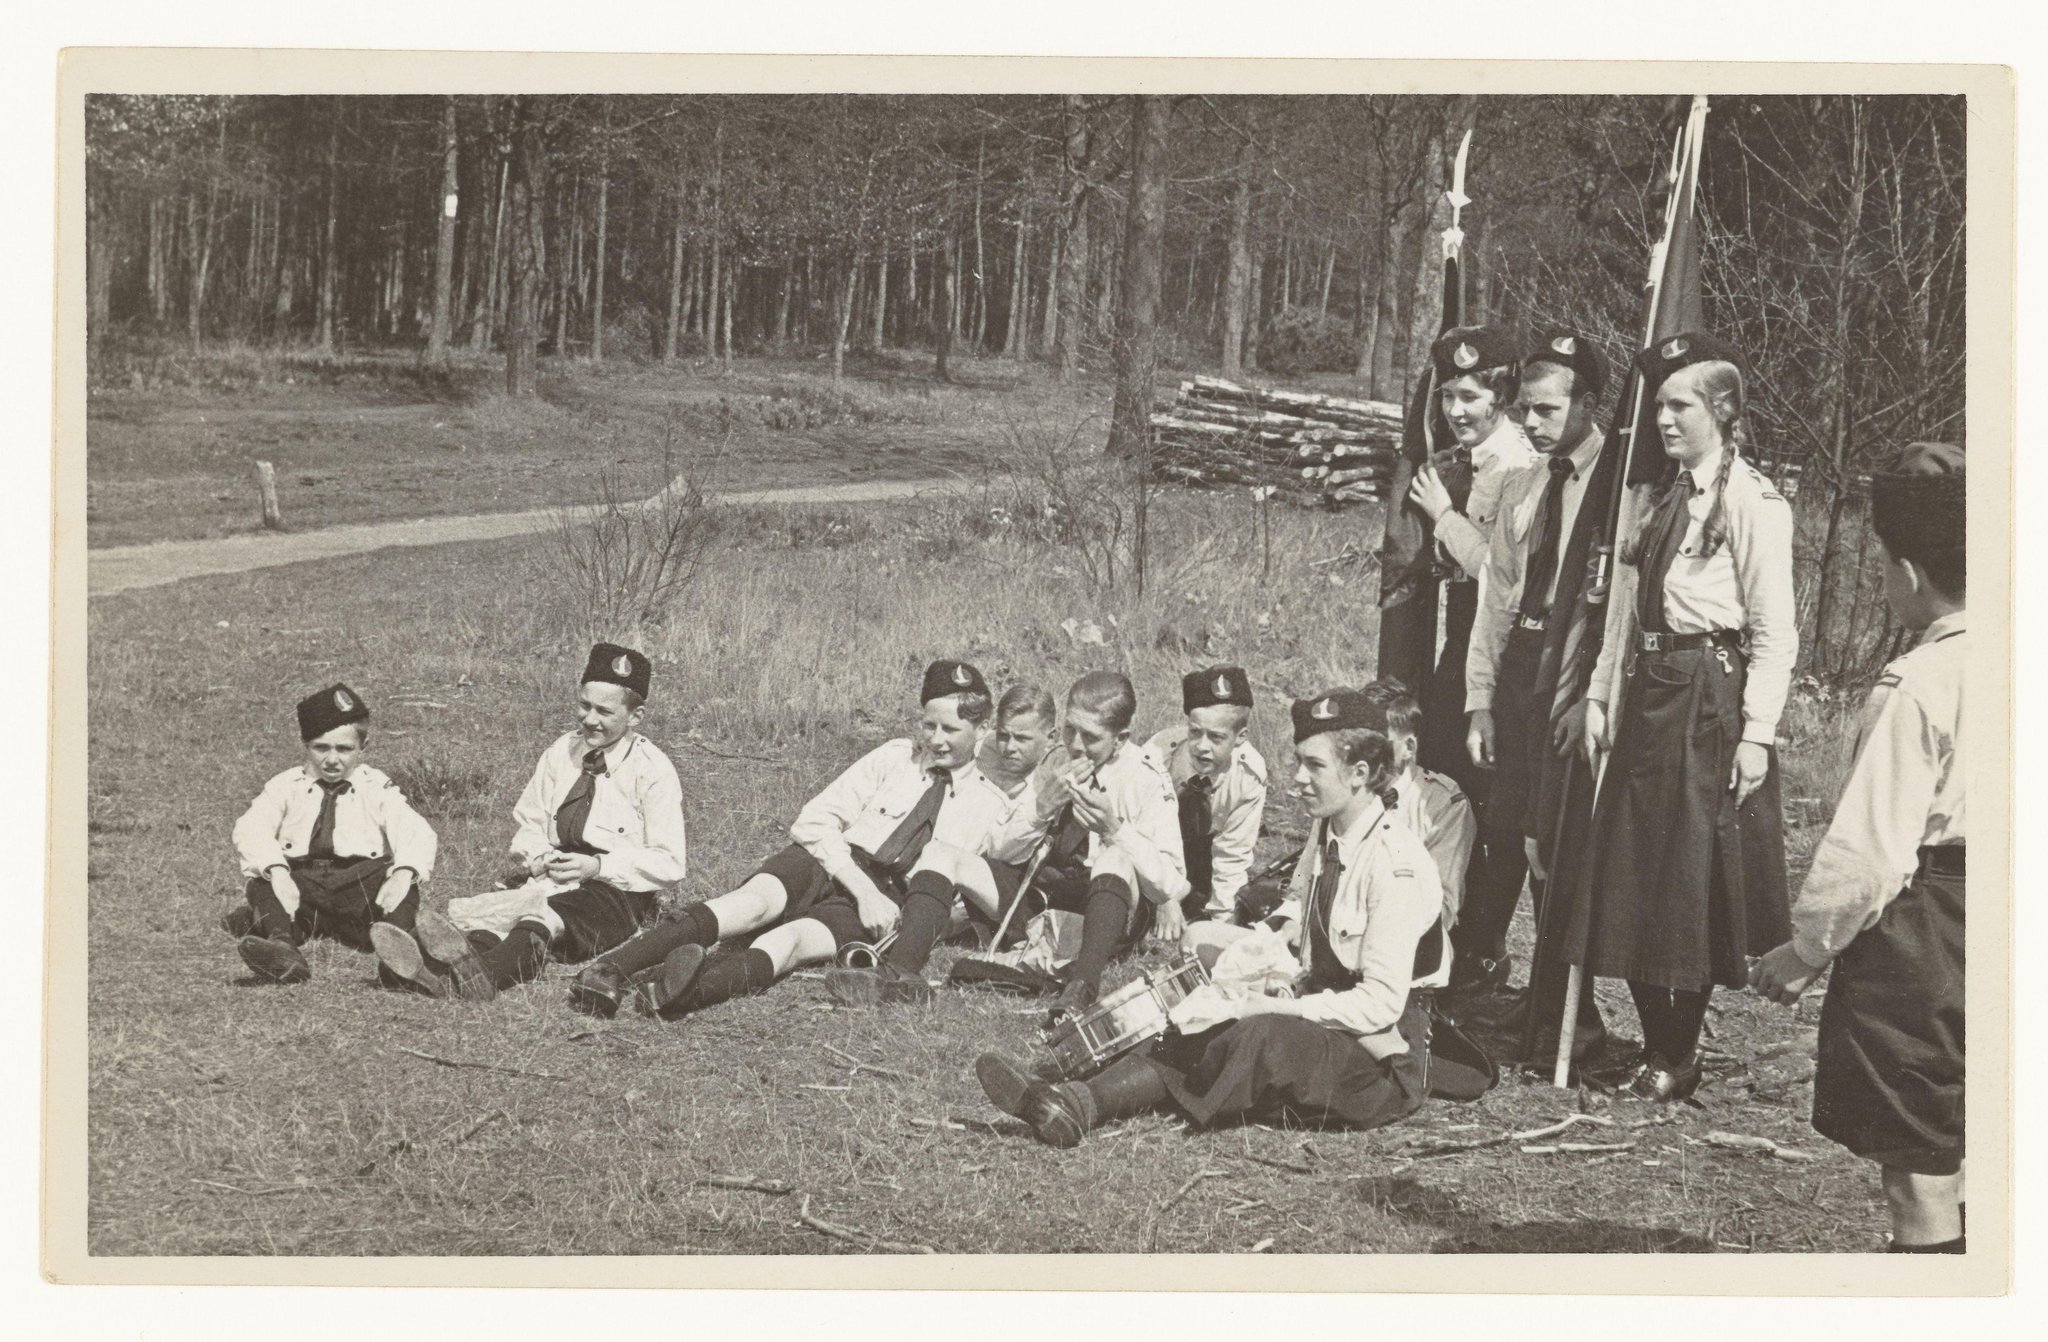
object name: photograph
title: Jeugdstorm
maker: j. otto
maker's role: fotograaf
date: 1935-1937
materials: photographic support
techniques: photography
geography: zeist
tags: military parade, pageant, zeist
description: In een bosachtige omgeving staan en zitten jongens en meisjes van de Jeugdstorm in uniform, vermoedelijk na afloop van de optocht. Twee staande meisjes houden ieder een vlag vast.Twee jongens zitten te eten, een meisje heeft een trommel op haar schoot. Op de achtergrond opgestapelde boomstammen.